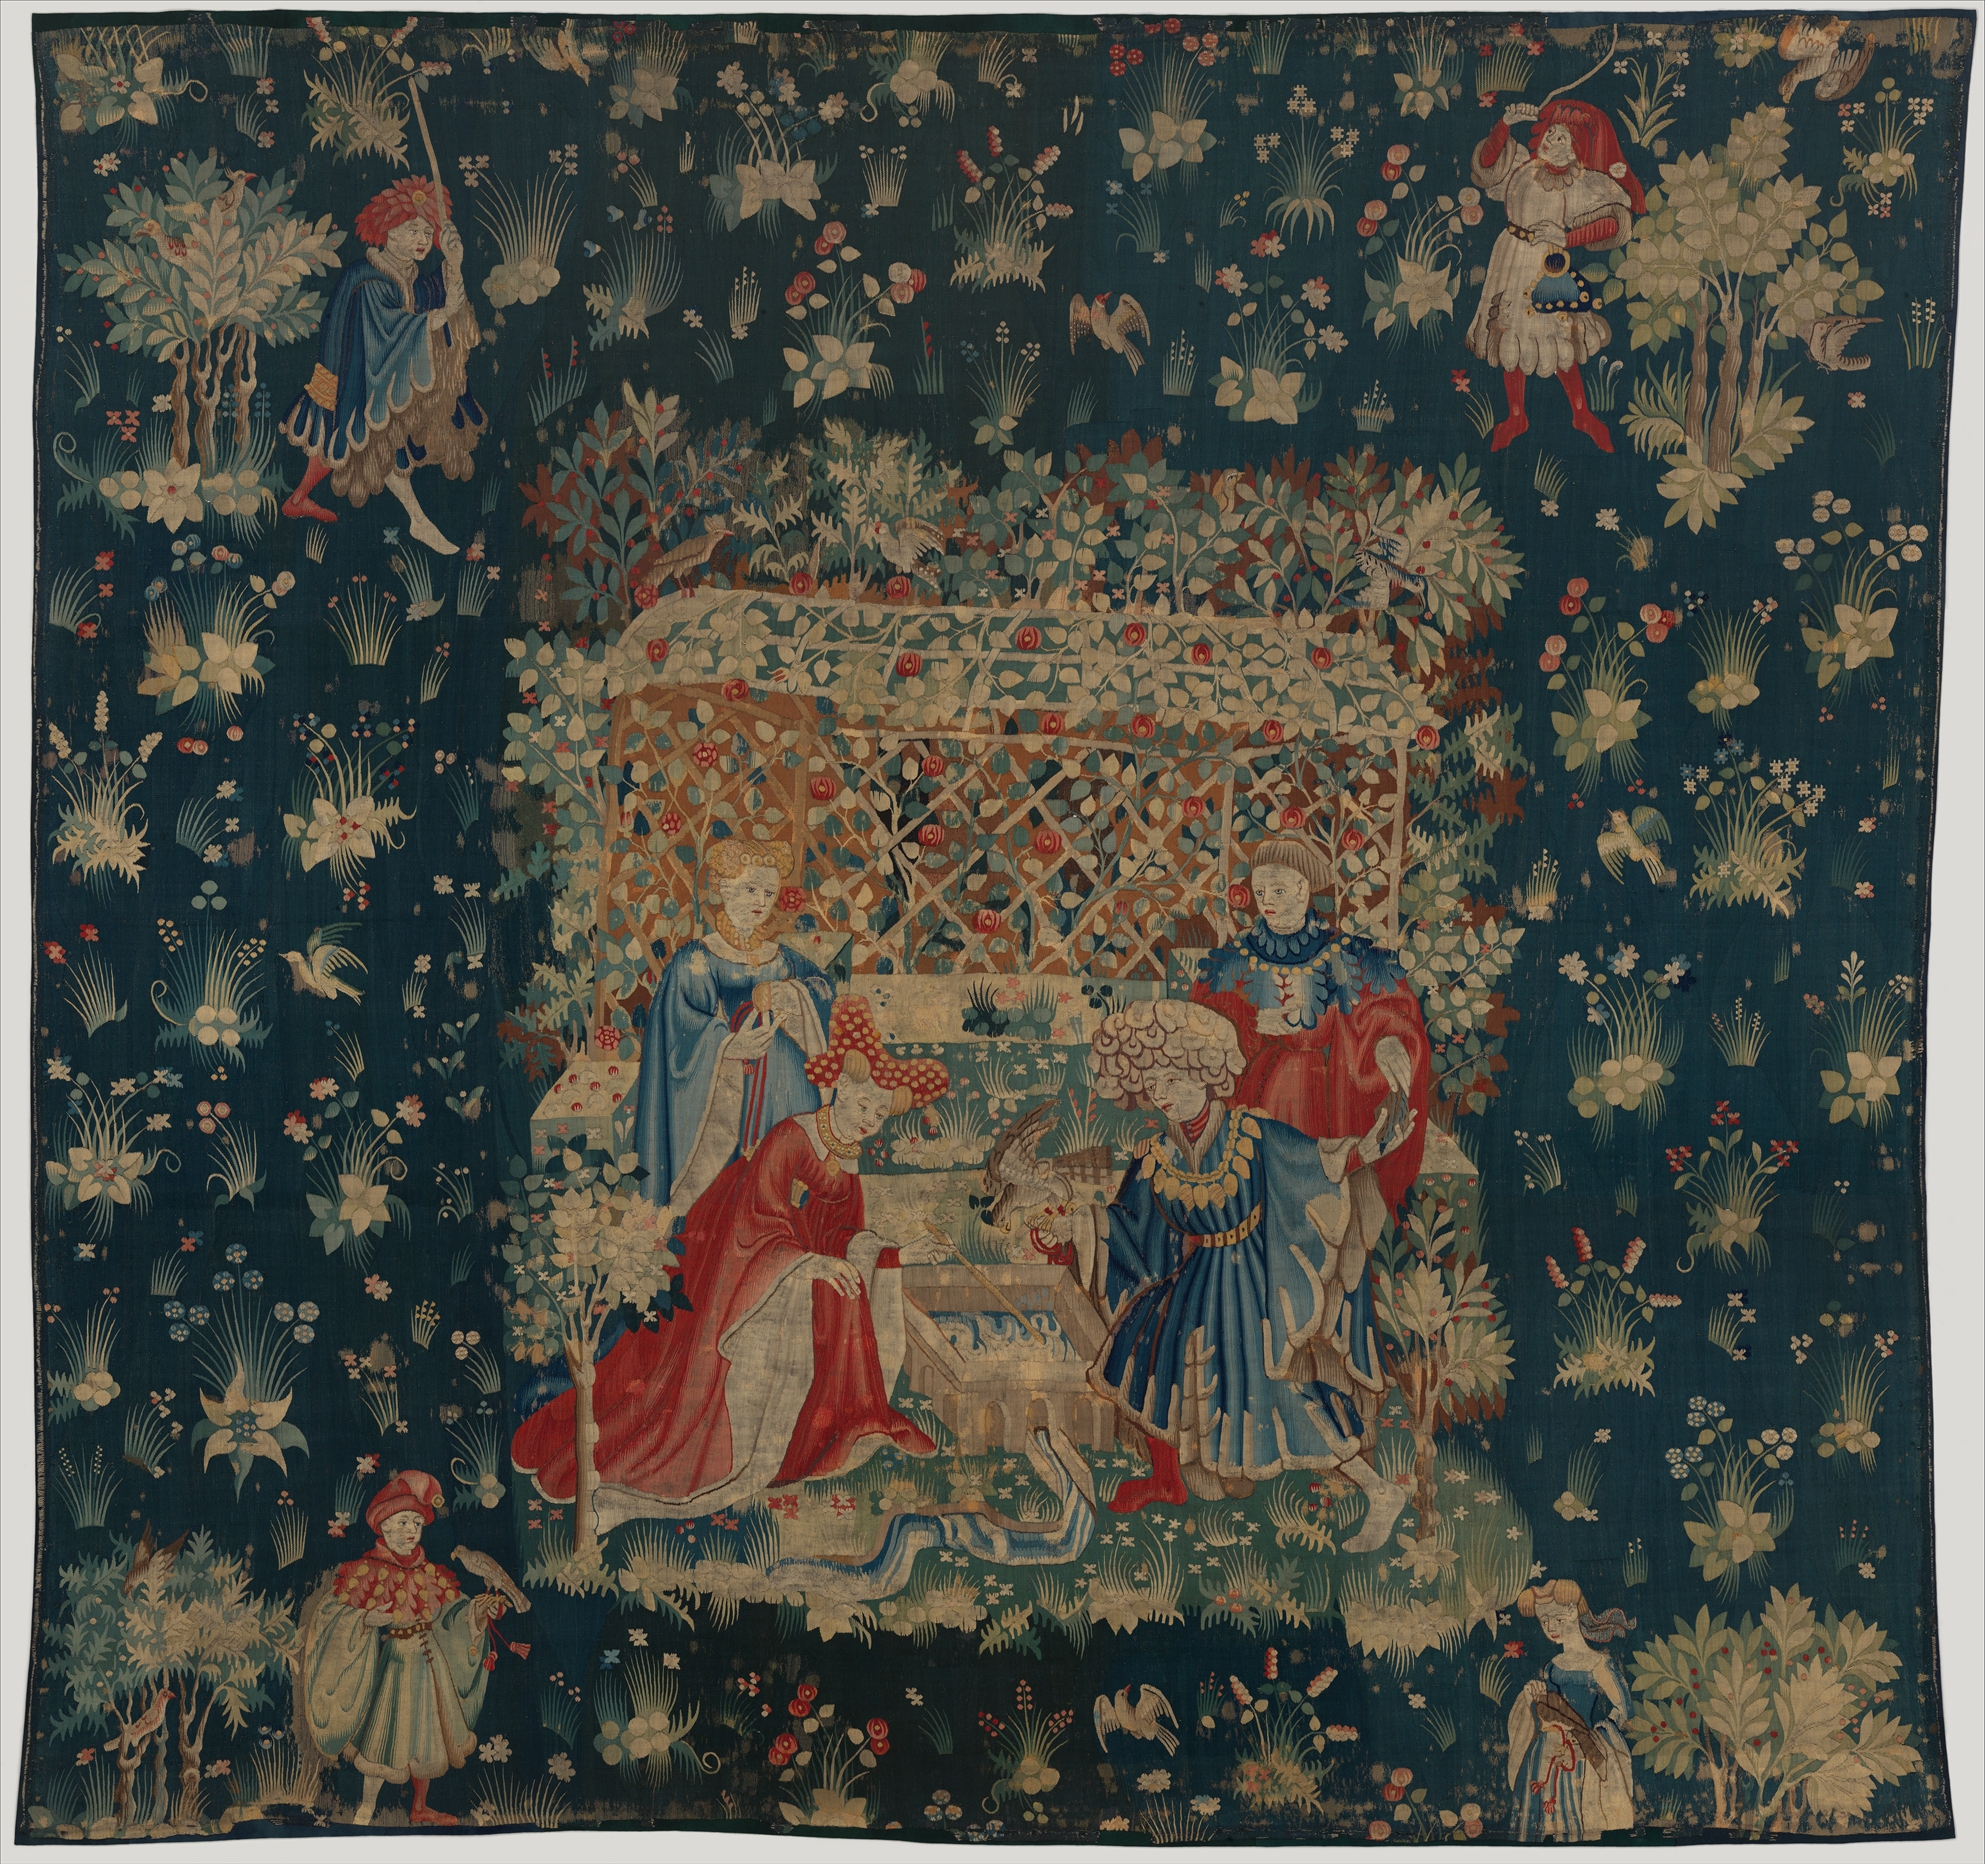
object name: tapestry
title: The Falcon's Bath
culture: south netherlandish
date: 1400-1415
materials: wool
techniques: tapestry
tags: birds,falcons,men,women,flowers